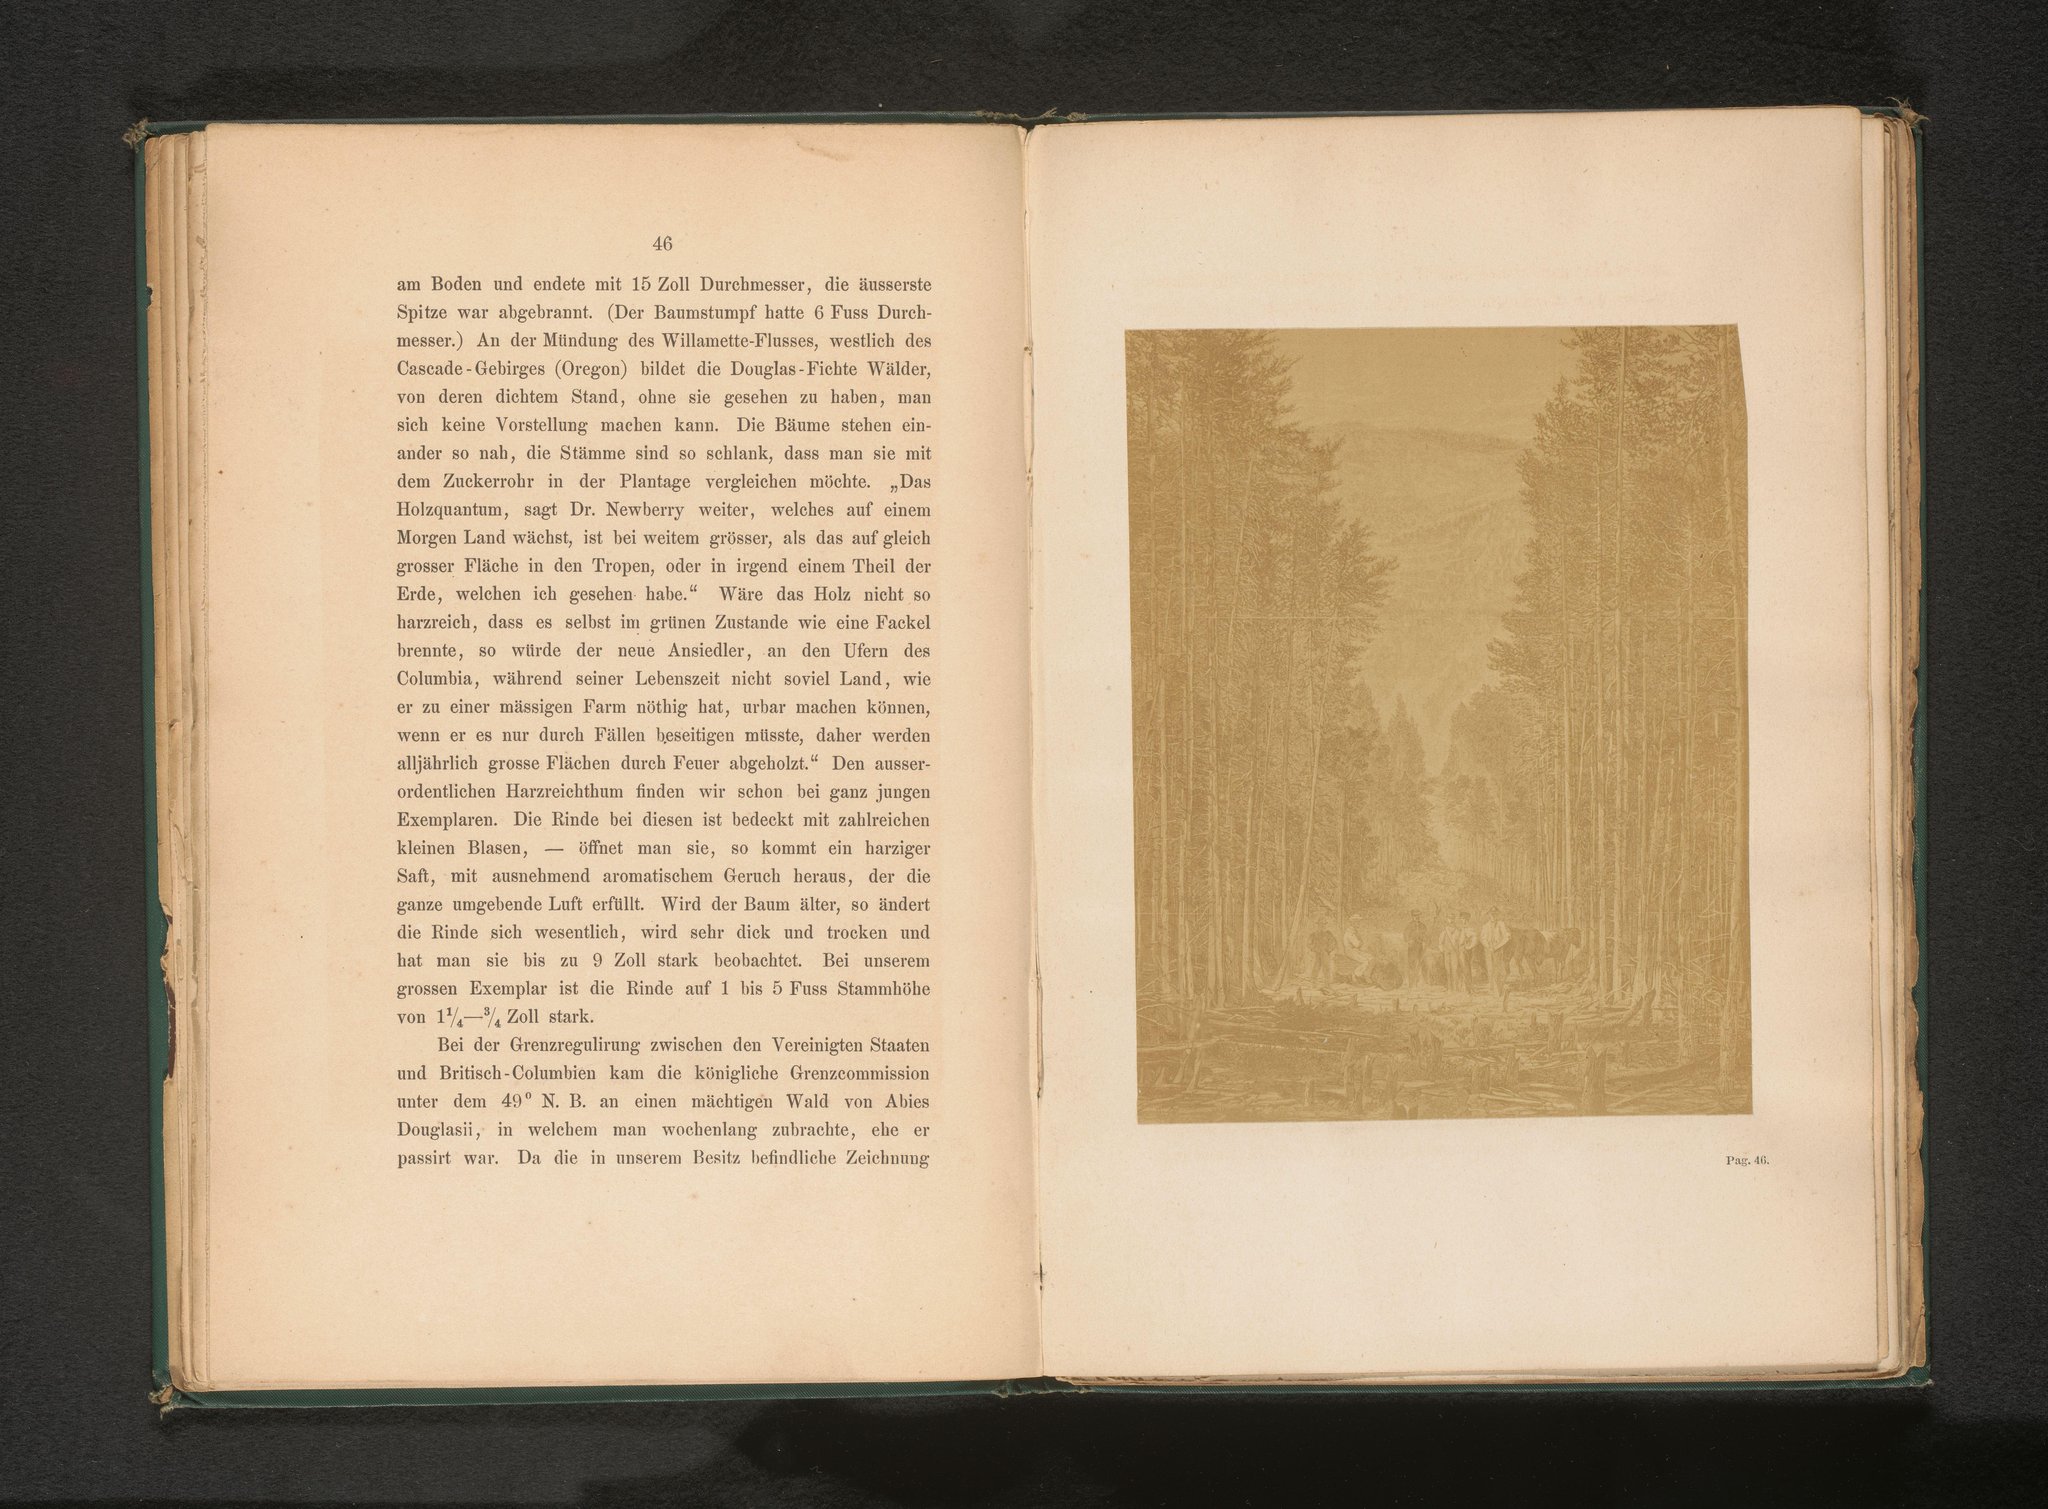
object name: photograph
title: Fotoreproductie van een tekening van houthakkers in een bos van Douglassparren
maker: Anonymous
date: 1867-1877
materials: photographic support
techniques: albumen print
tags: woodcutting, woodcutter ~ forestry, trees: fir